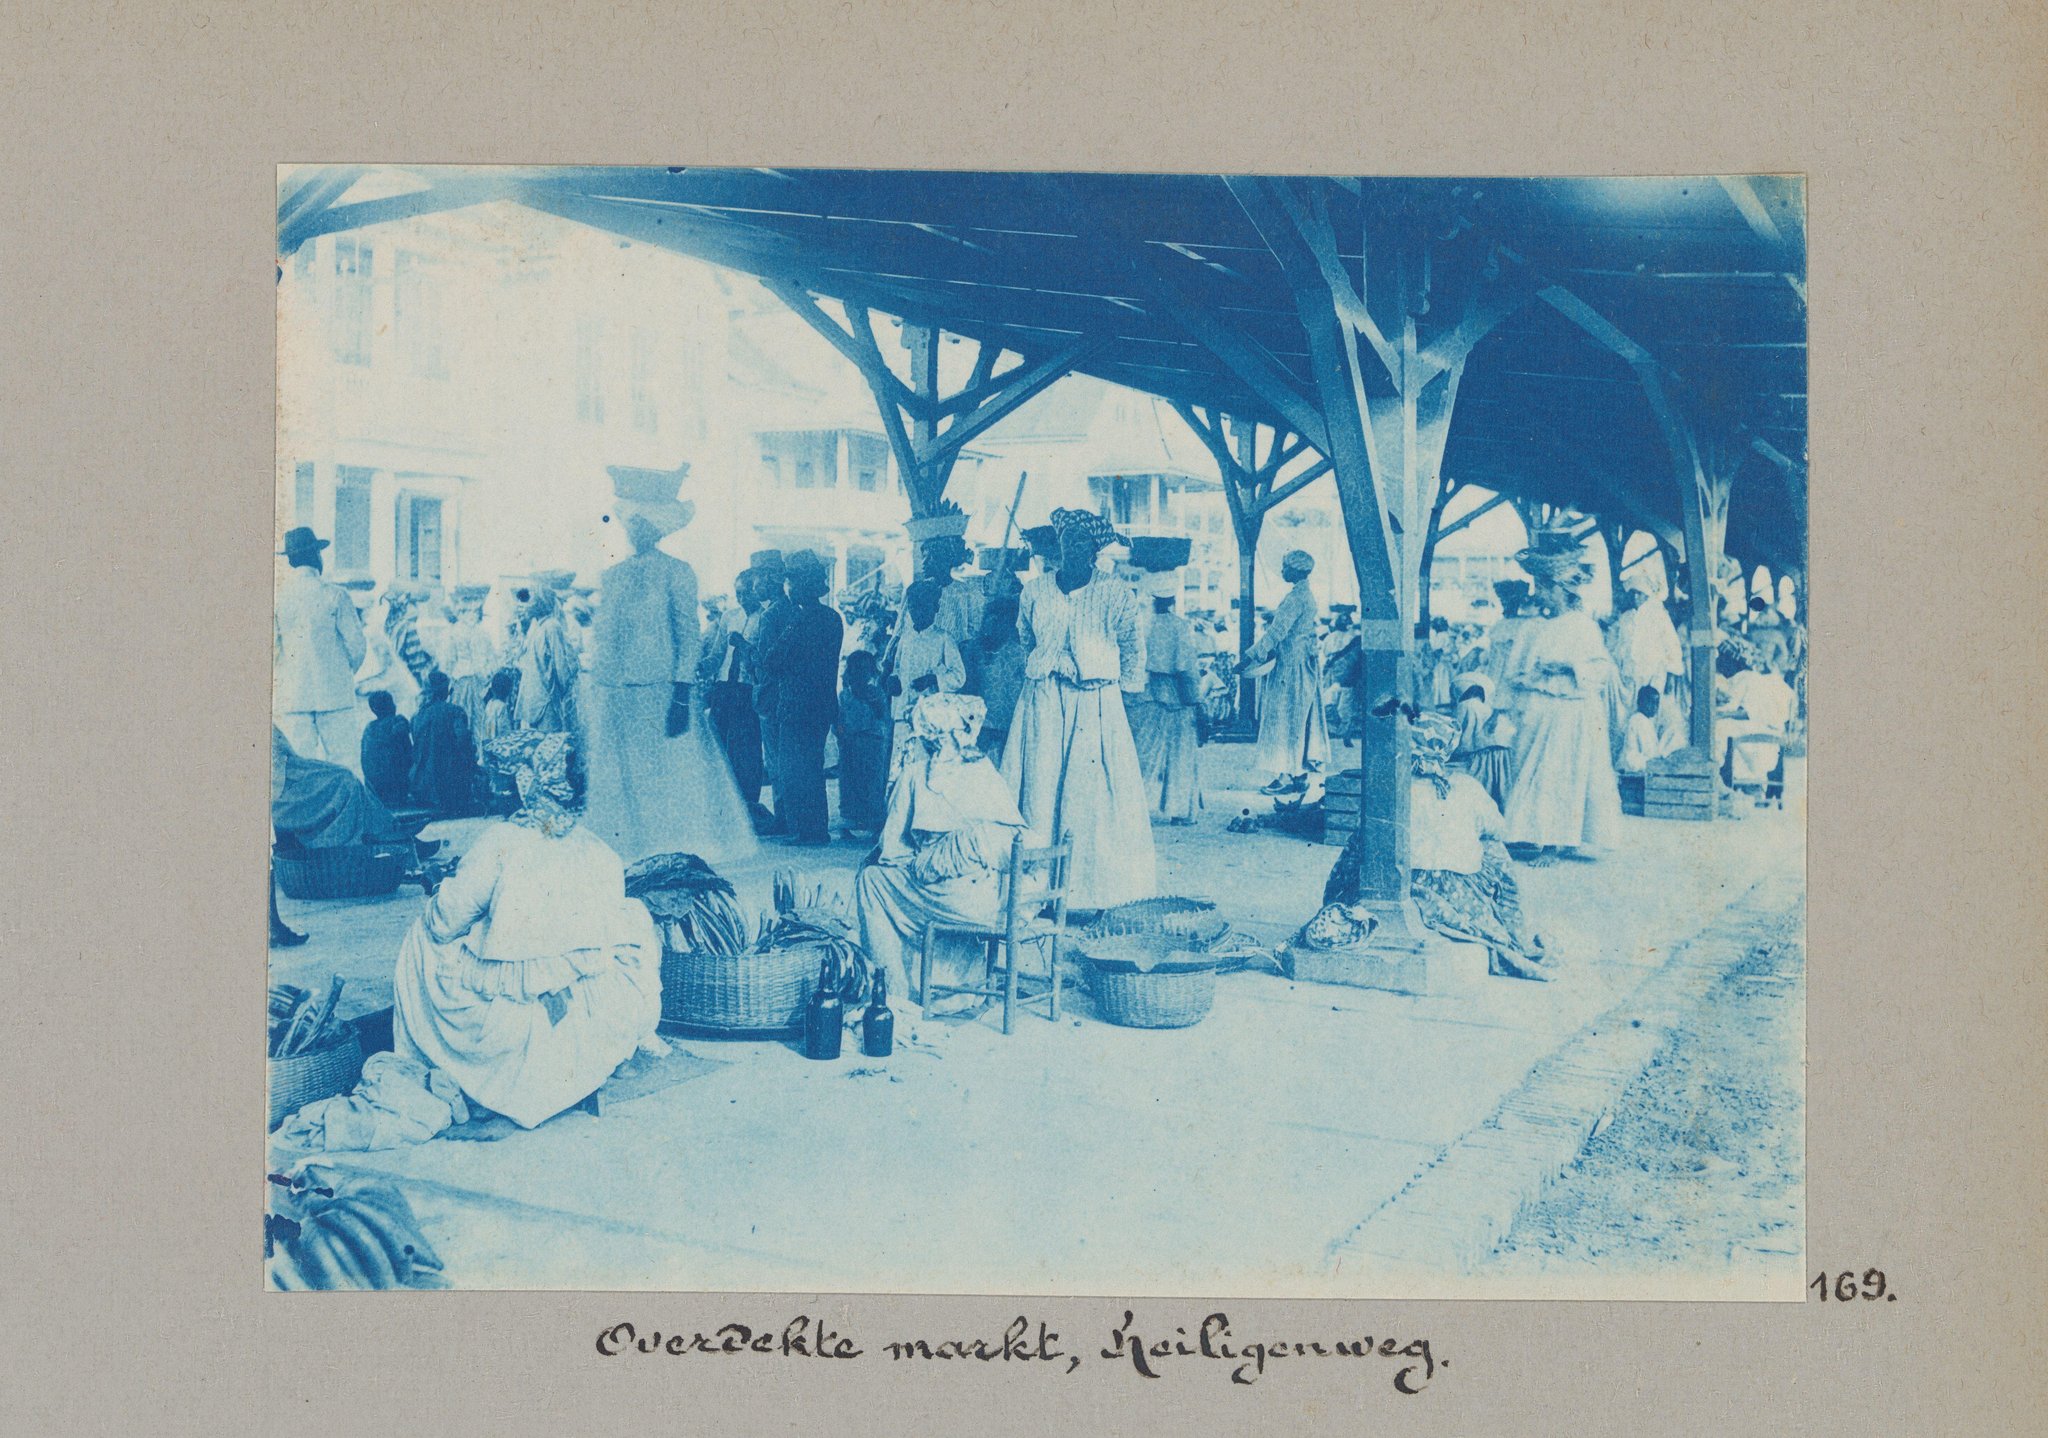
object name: photograph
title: Overdekte markt, Heiligenweg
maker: hendrik doijer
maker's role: engineer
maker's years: 1863-1925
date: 1903-1910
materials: photographic support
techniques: cyanotype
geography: suriname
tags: suriname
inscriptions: inscription: ‘169. / Overdekte markt, Heiligenweg.’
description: Gezicht op de overdekte markt aan de Heiligenweg te Paramaribo. Marktverkoopsters zitten tussen hun waren op de grond. Onderdeel van het fotoalbum Souvenir de Voyage (deel 5), over het leven van de familie Doijer in en rond de plantage Ma Retraite in Suriname in de jaren 1903-1910.